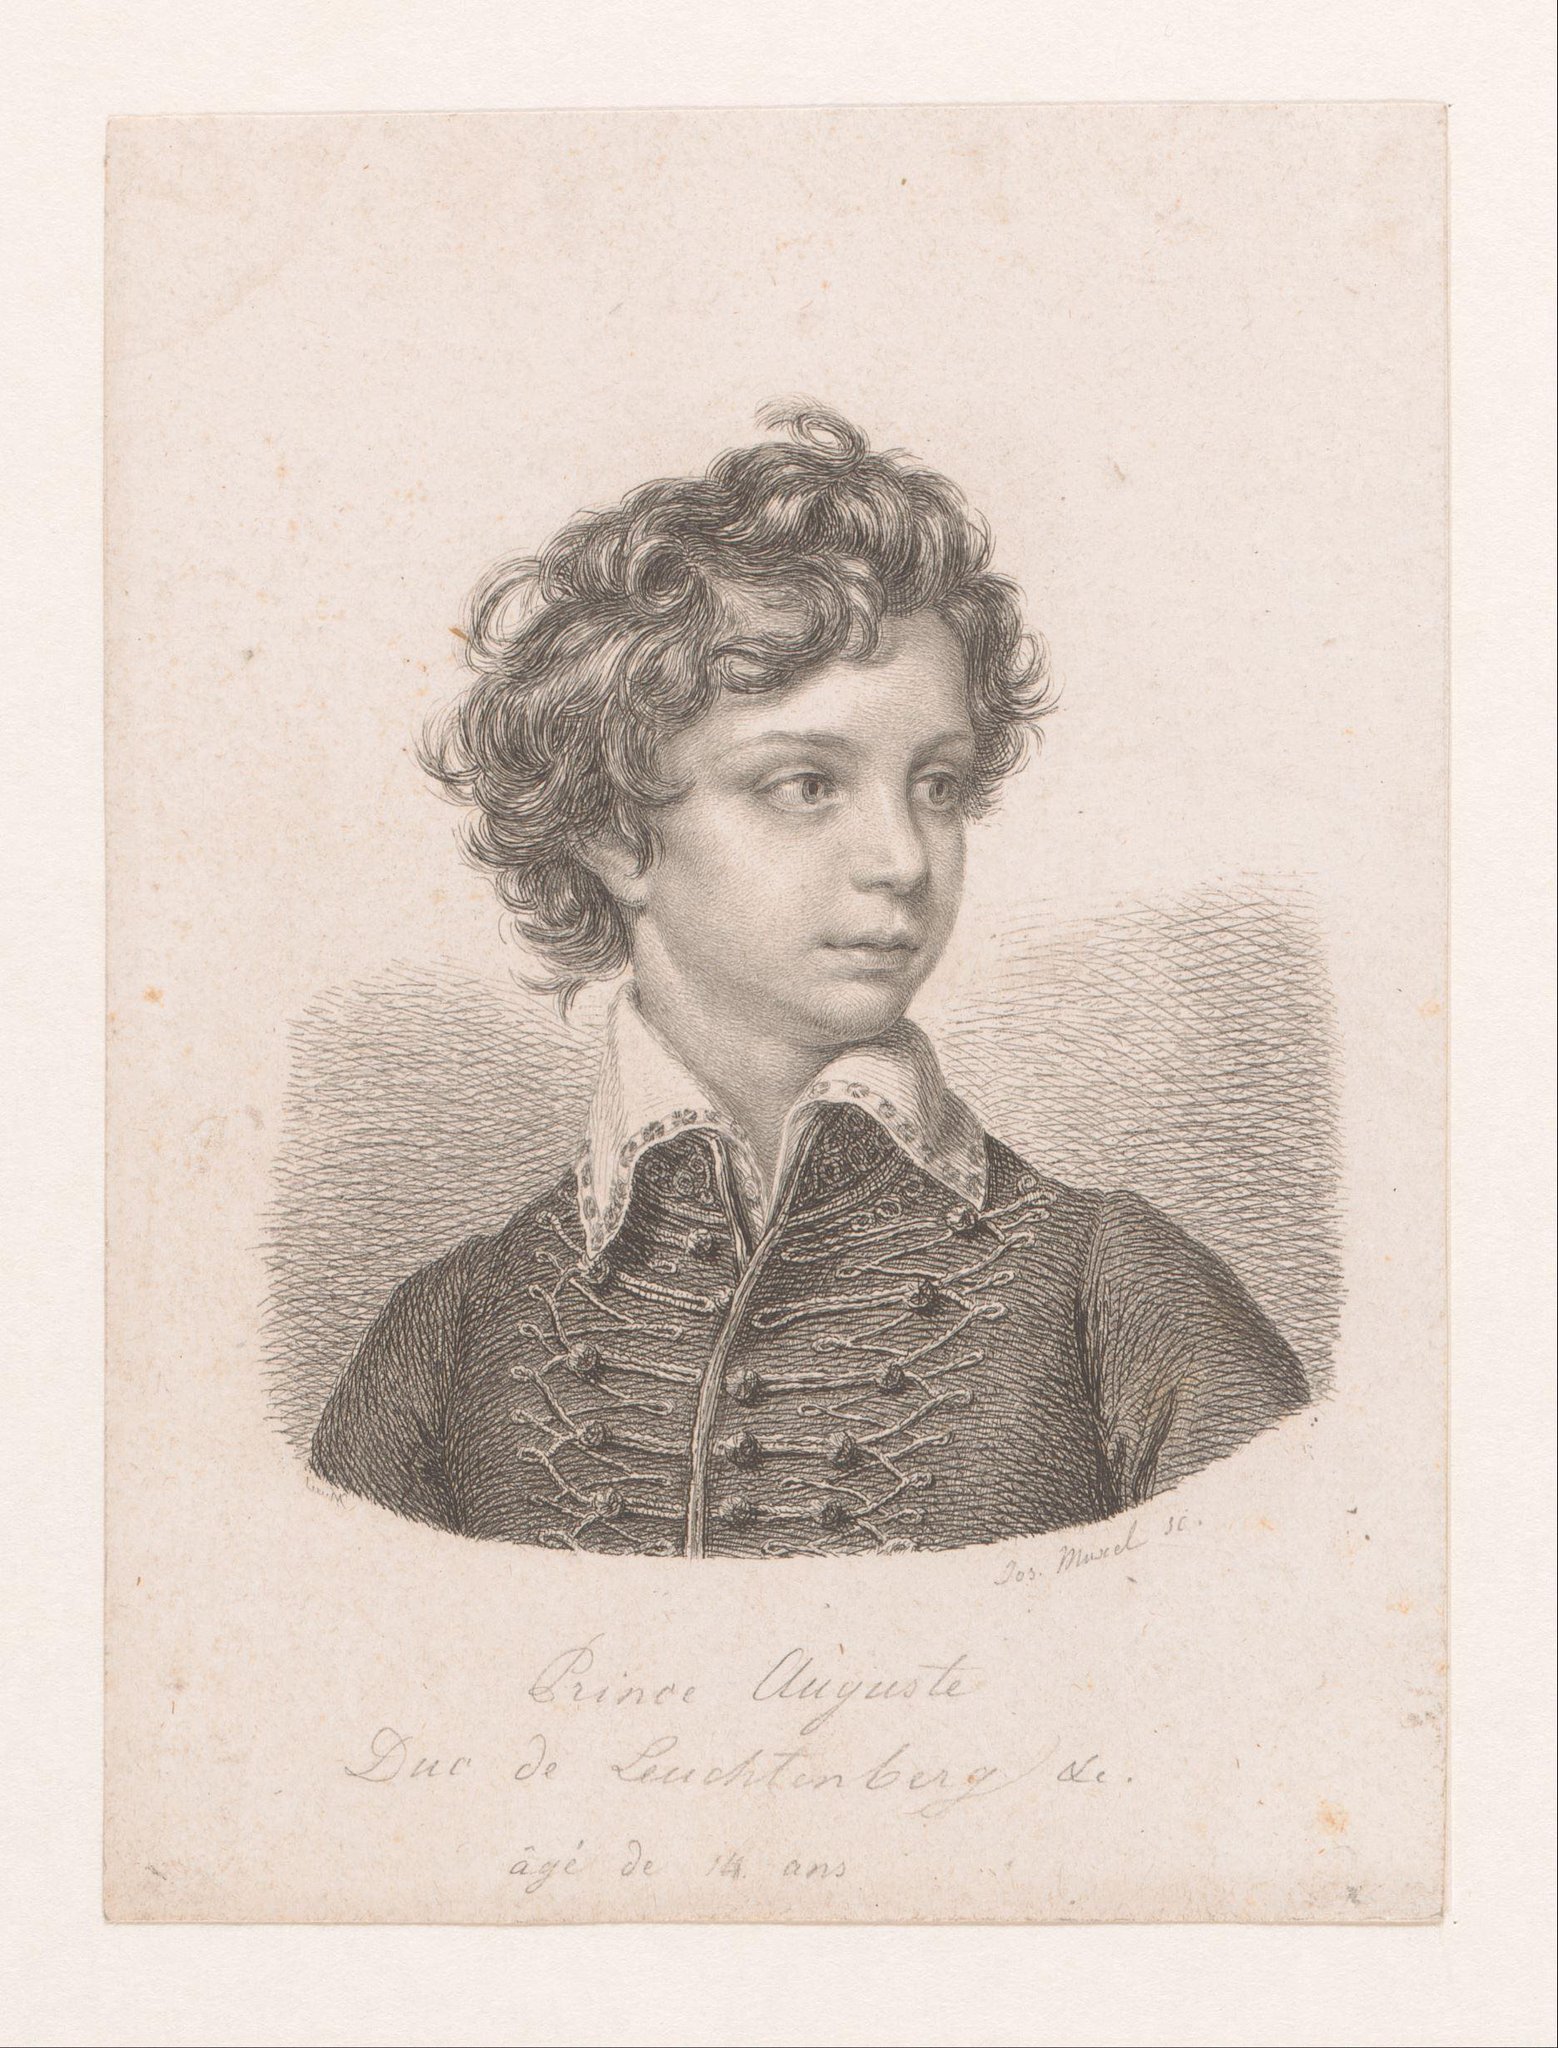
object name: print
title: Portret van August van Leuchtenberg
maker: johann nepomuk muxel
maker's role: print maker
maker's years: 1790-1870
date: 1815-1870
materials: paper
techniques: etching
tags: august van leuchtenberg, historical persons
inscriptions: collector's mark: Lugt 2228, : ‘Prince Auguste Duc de Luchtenburg etc. àgé de 14 ans’